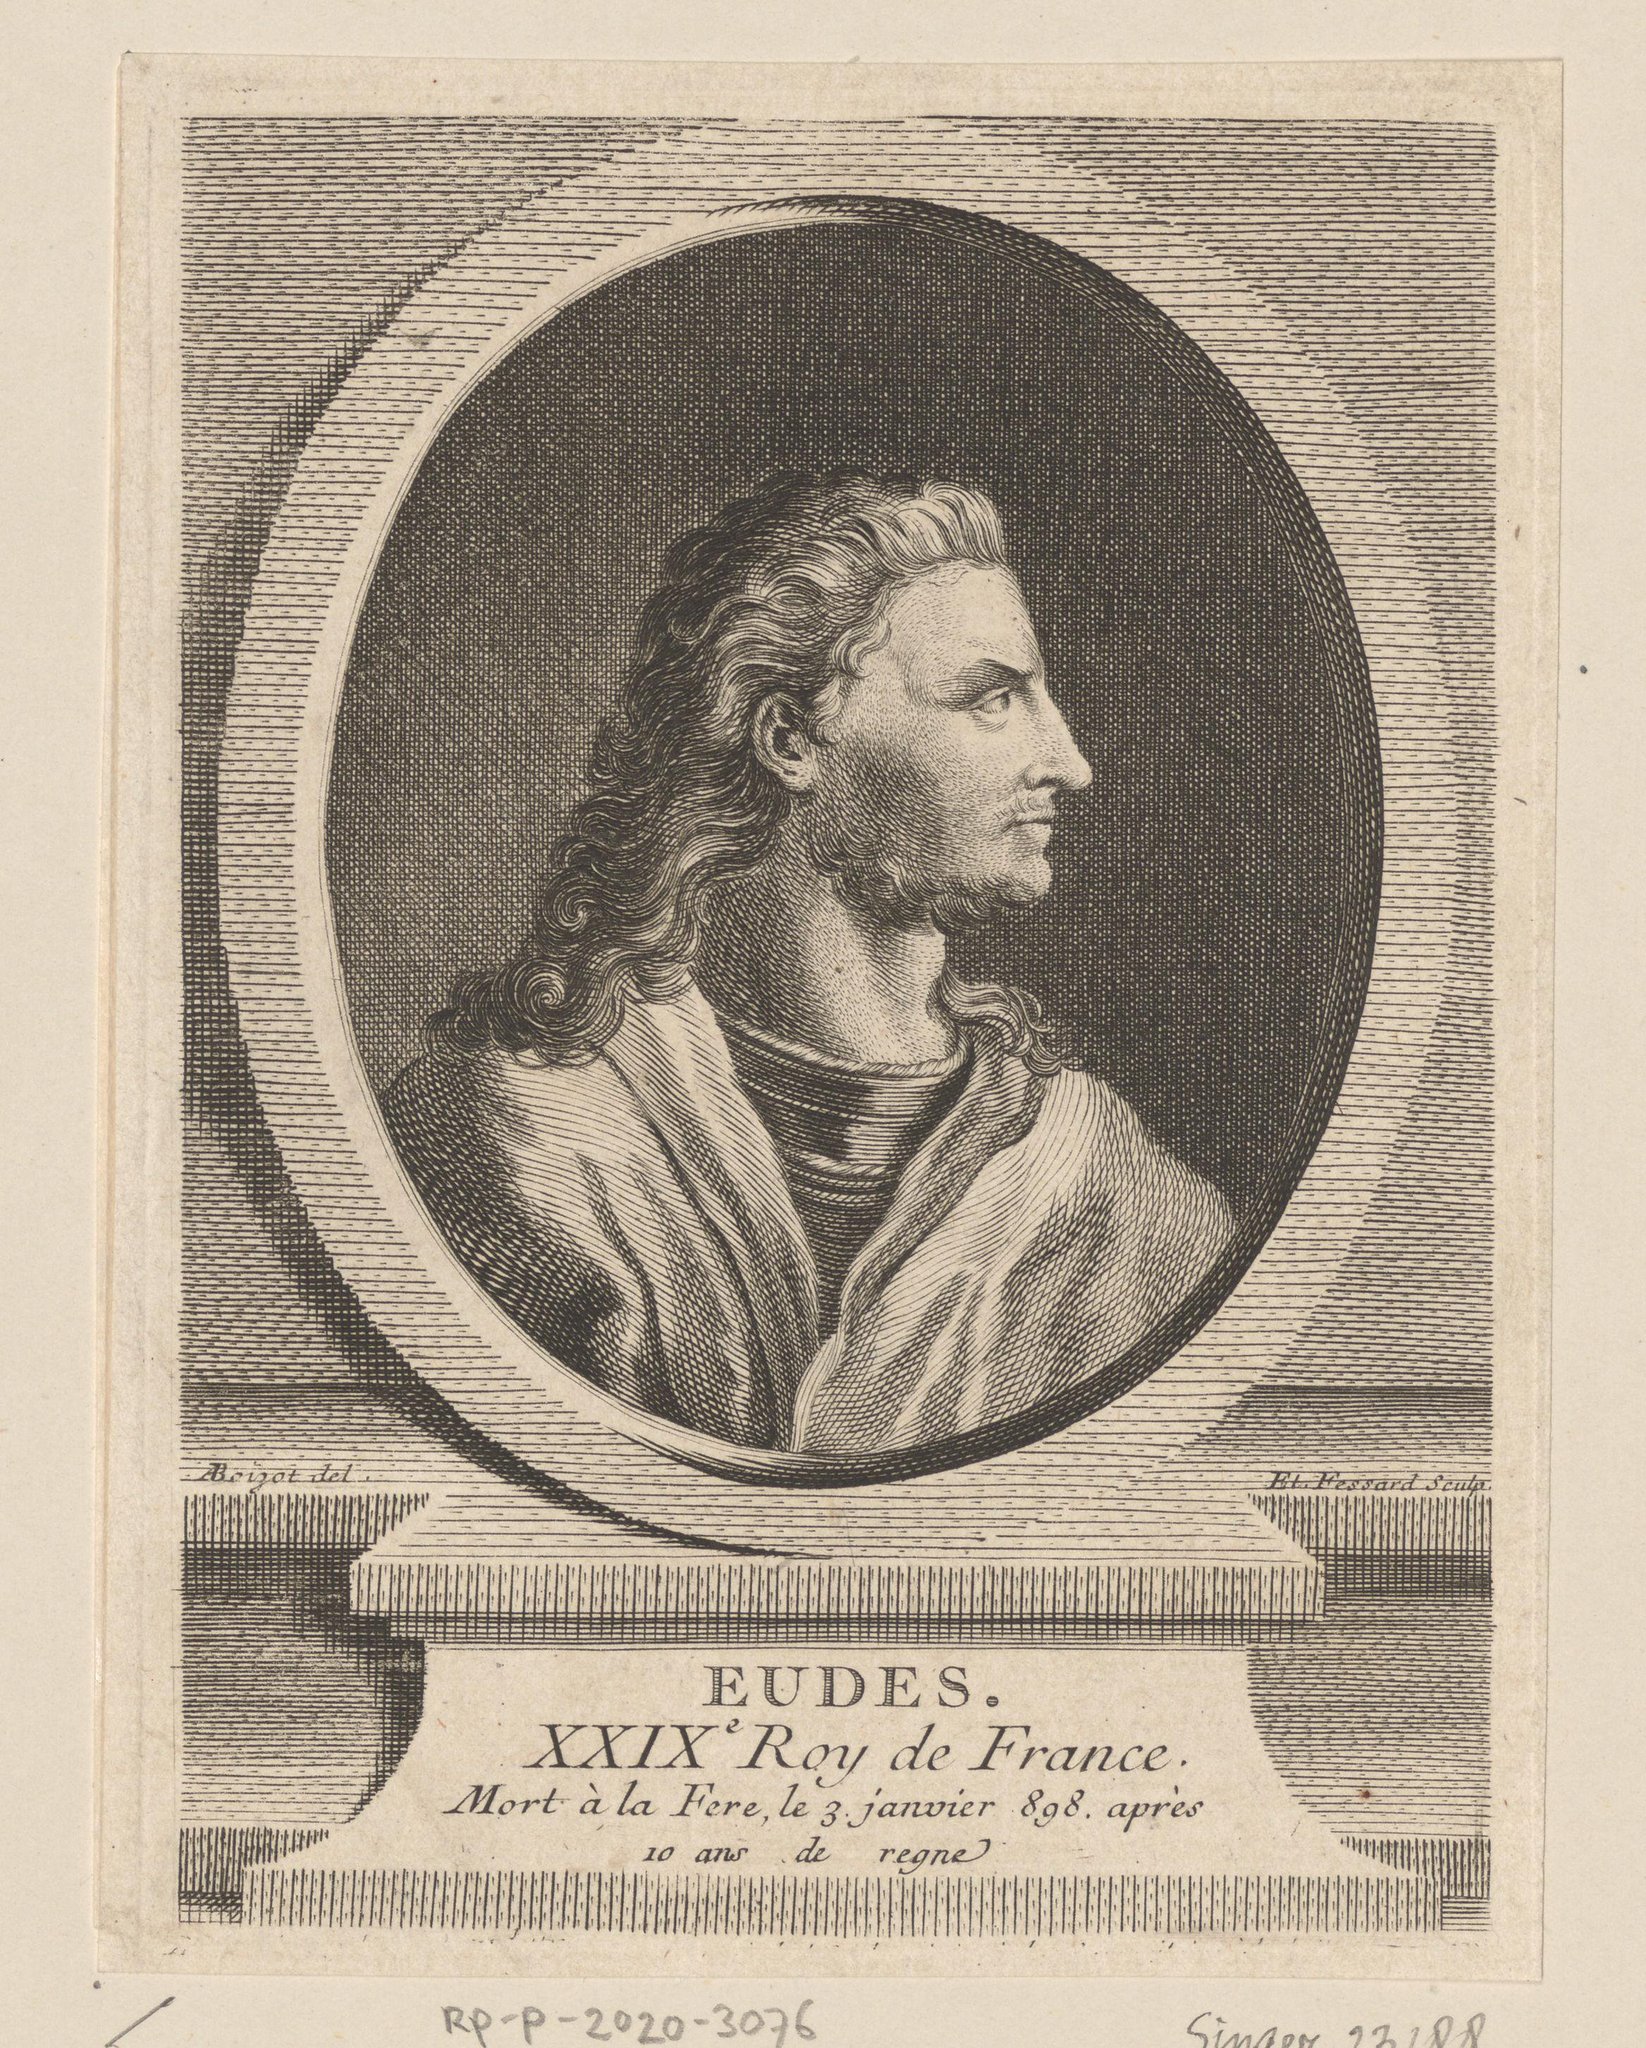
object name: print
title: Portret van Odo I van Frankrijk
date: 1741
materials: paper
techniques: etching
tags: historical persons, king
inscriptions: collector's mark: Lugt 2228